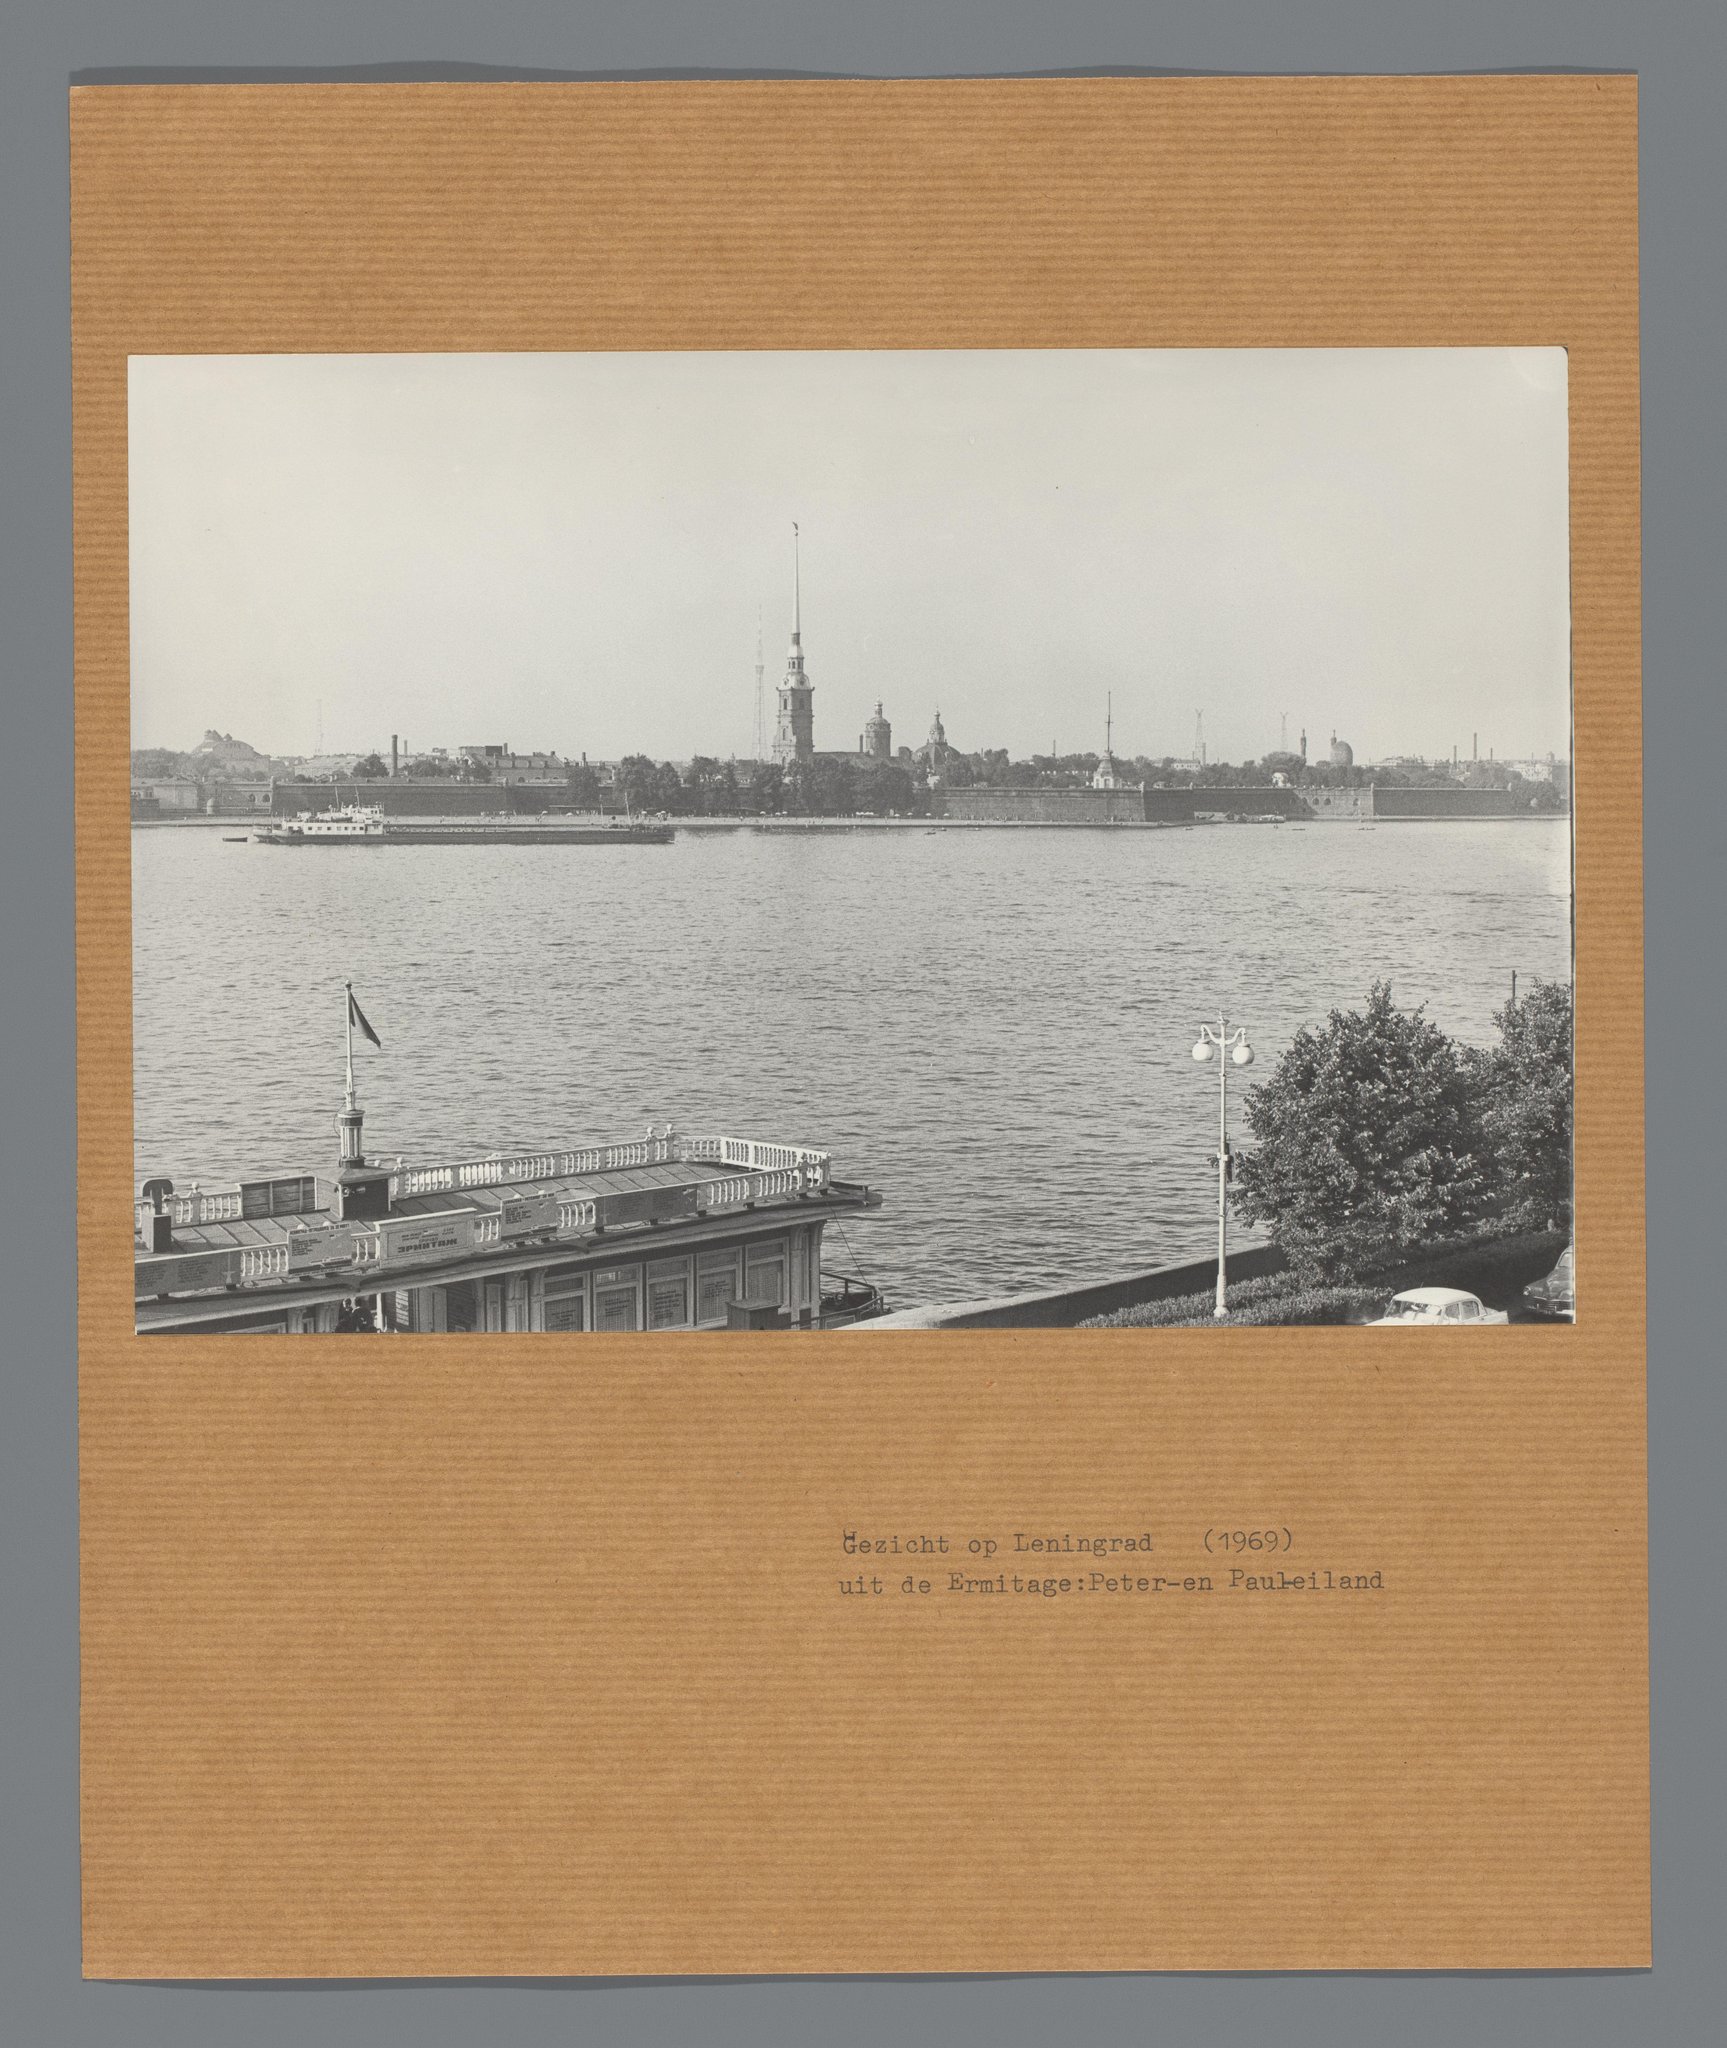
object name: photograph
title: Gezicht op Leningrad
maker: Anonymous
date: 1969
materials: photographic support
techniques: gelatin silver print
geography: russia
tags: leningrad